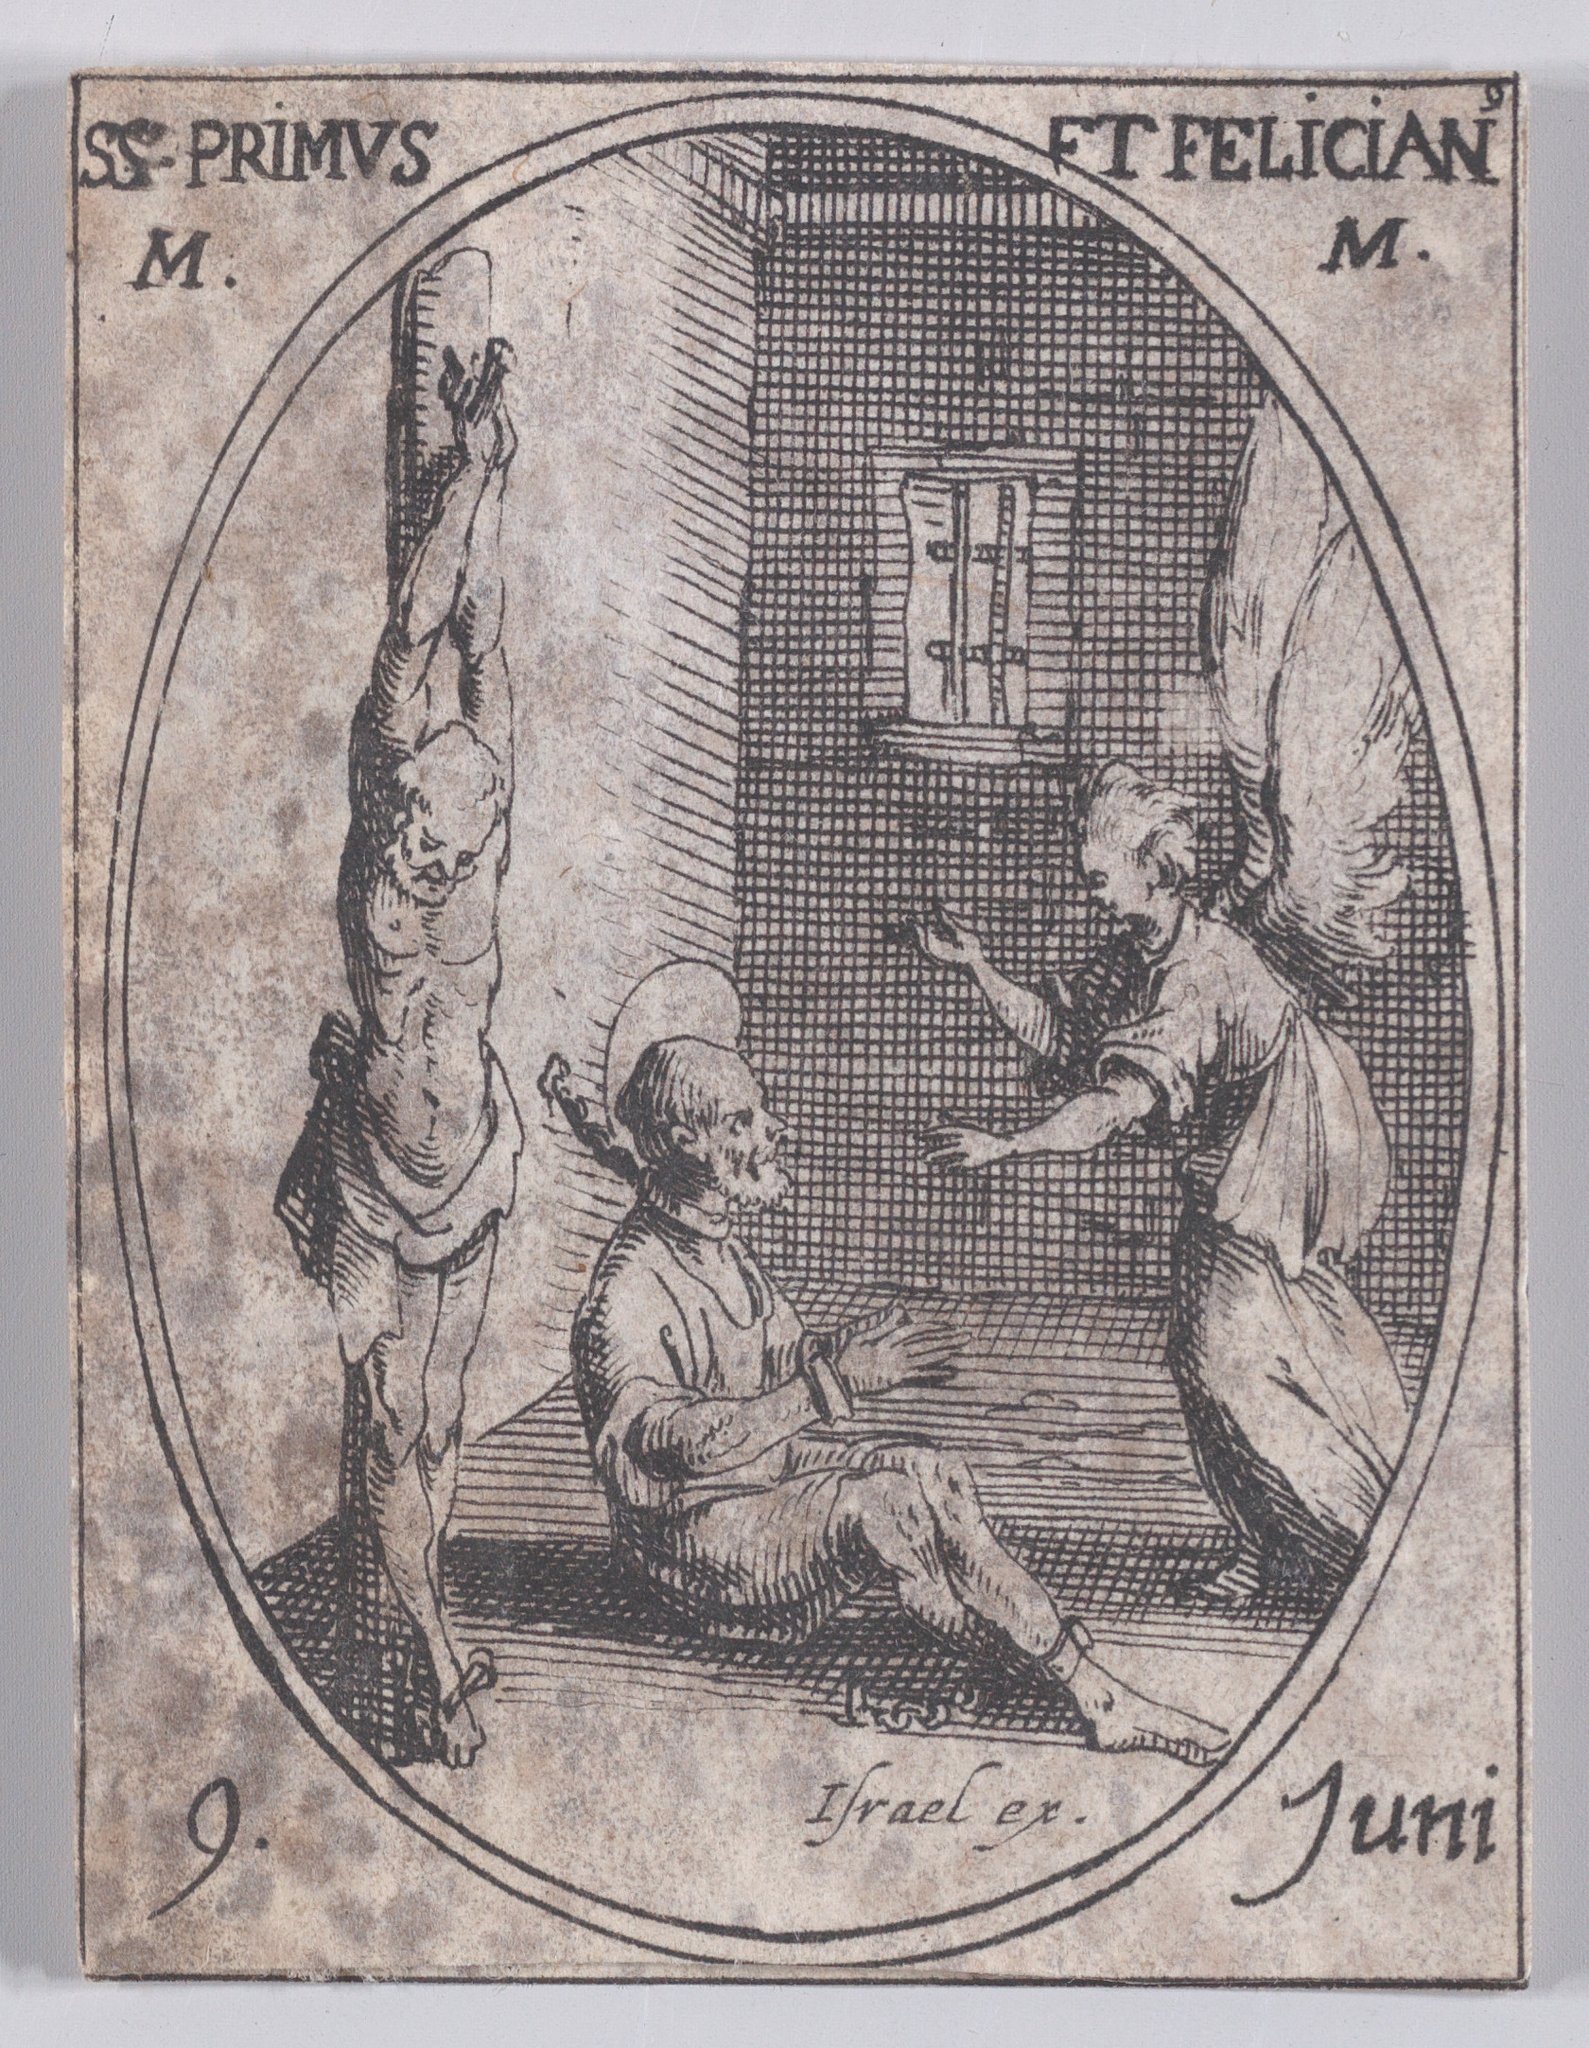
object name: print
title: S. Prime et S. Félicien, martyrs (St. Primus and St. Felician, Martyrs), June 9th, from "Les Images De Tous Les Saincts et Saintes de L'Année" (Images of All of the Saints and Religious Events of the Year)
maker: jacques callot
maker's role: artist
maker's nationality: french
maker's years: 1592-1635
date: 1636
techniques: etching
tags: men,angels,saints